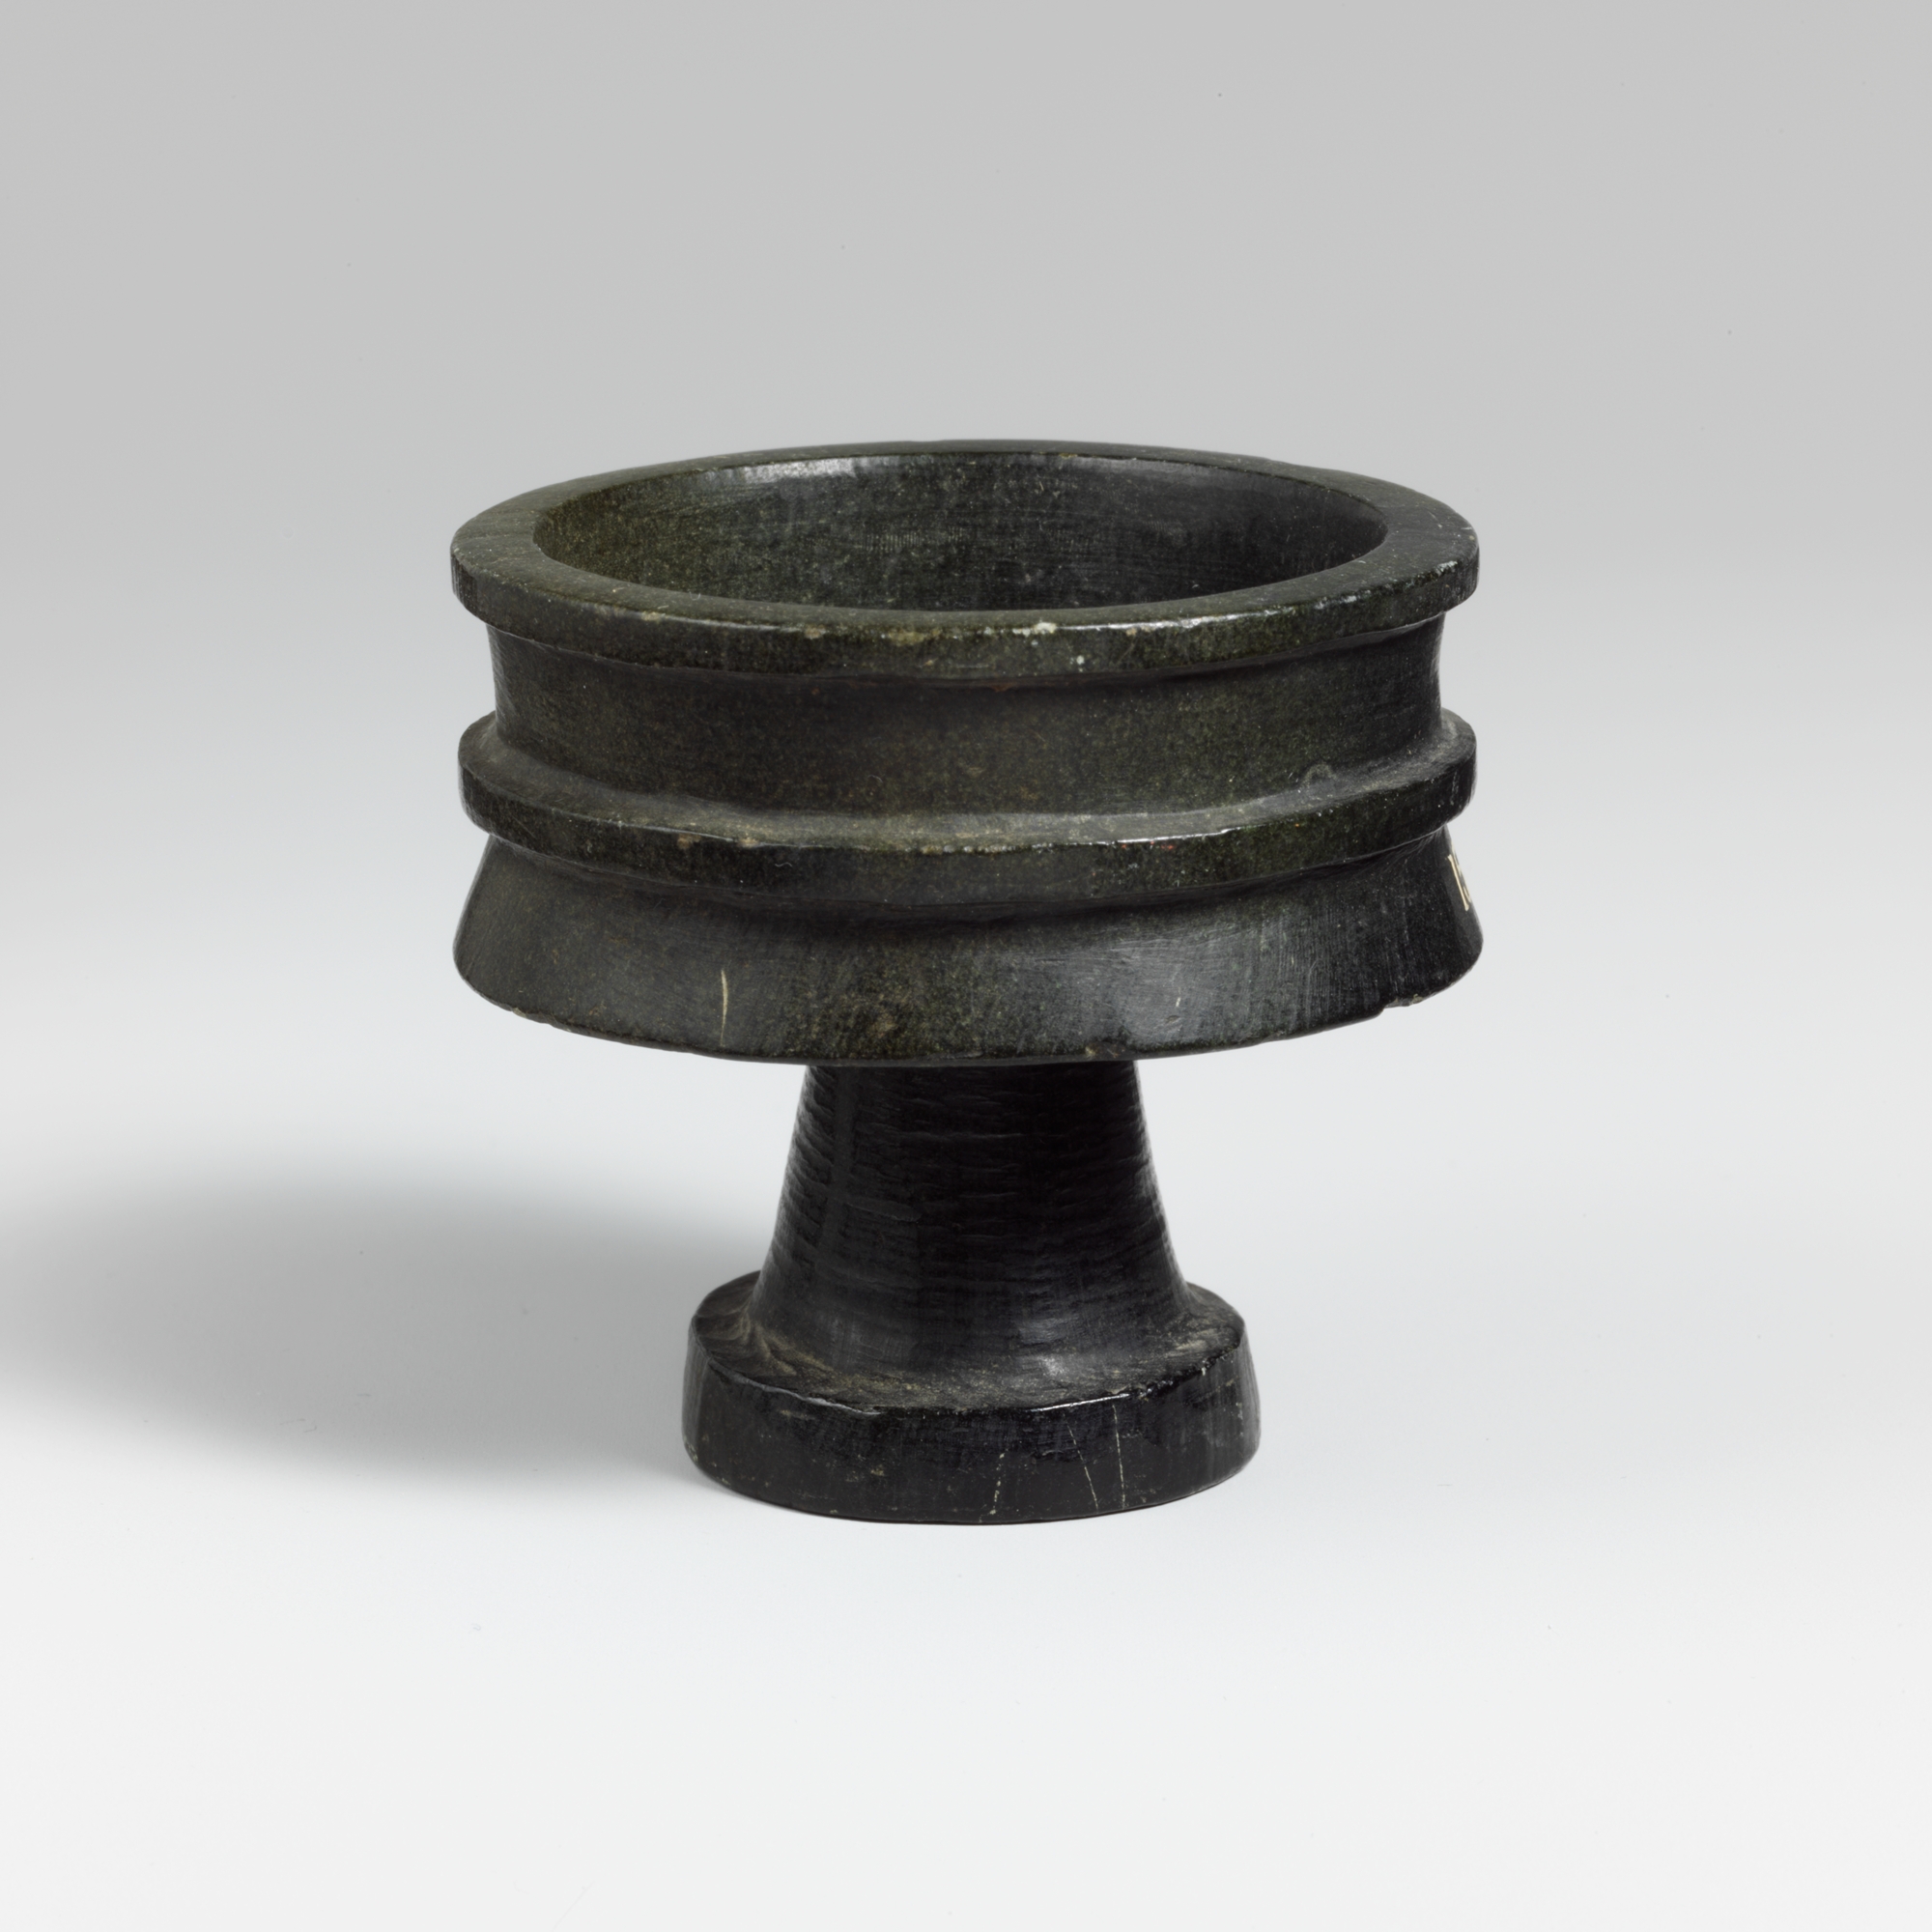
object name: bowl, stemmed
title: Miniature chlorite stemmed bowl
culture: cypriot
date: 1600-1200 BCE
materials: mineral